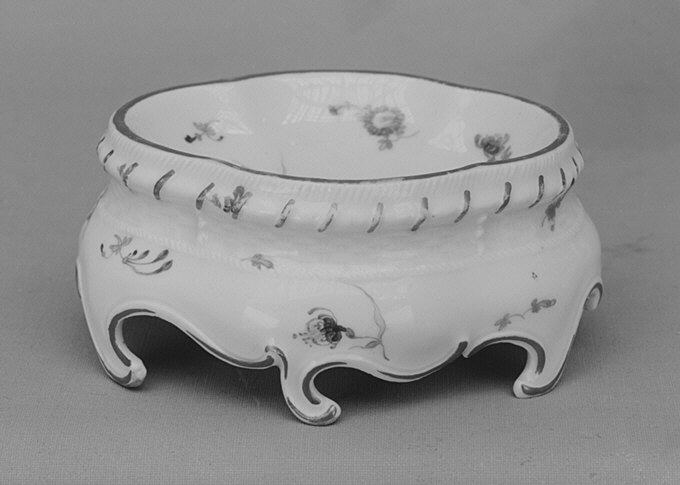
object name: salt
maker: frankenthal porcelain manufactory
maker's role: manufactory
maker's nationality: german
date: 1759-1762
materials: hard paste porcelain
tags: flowers